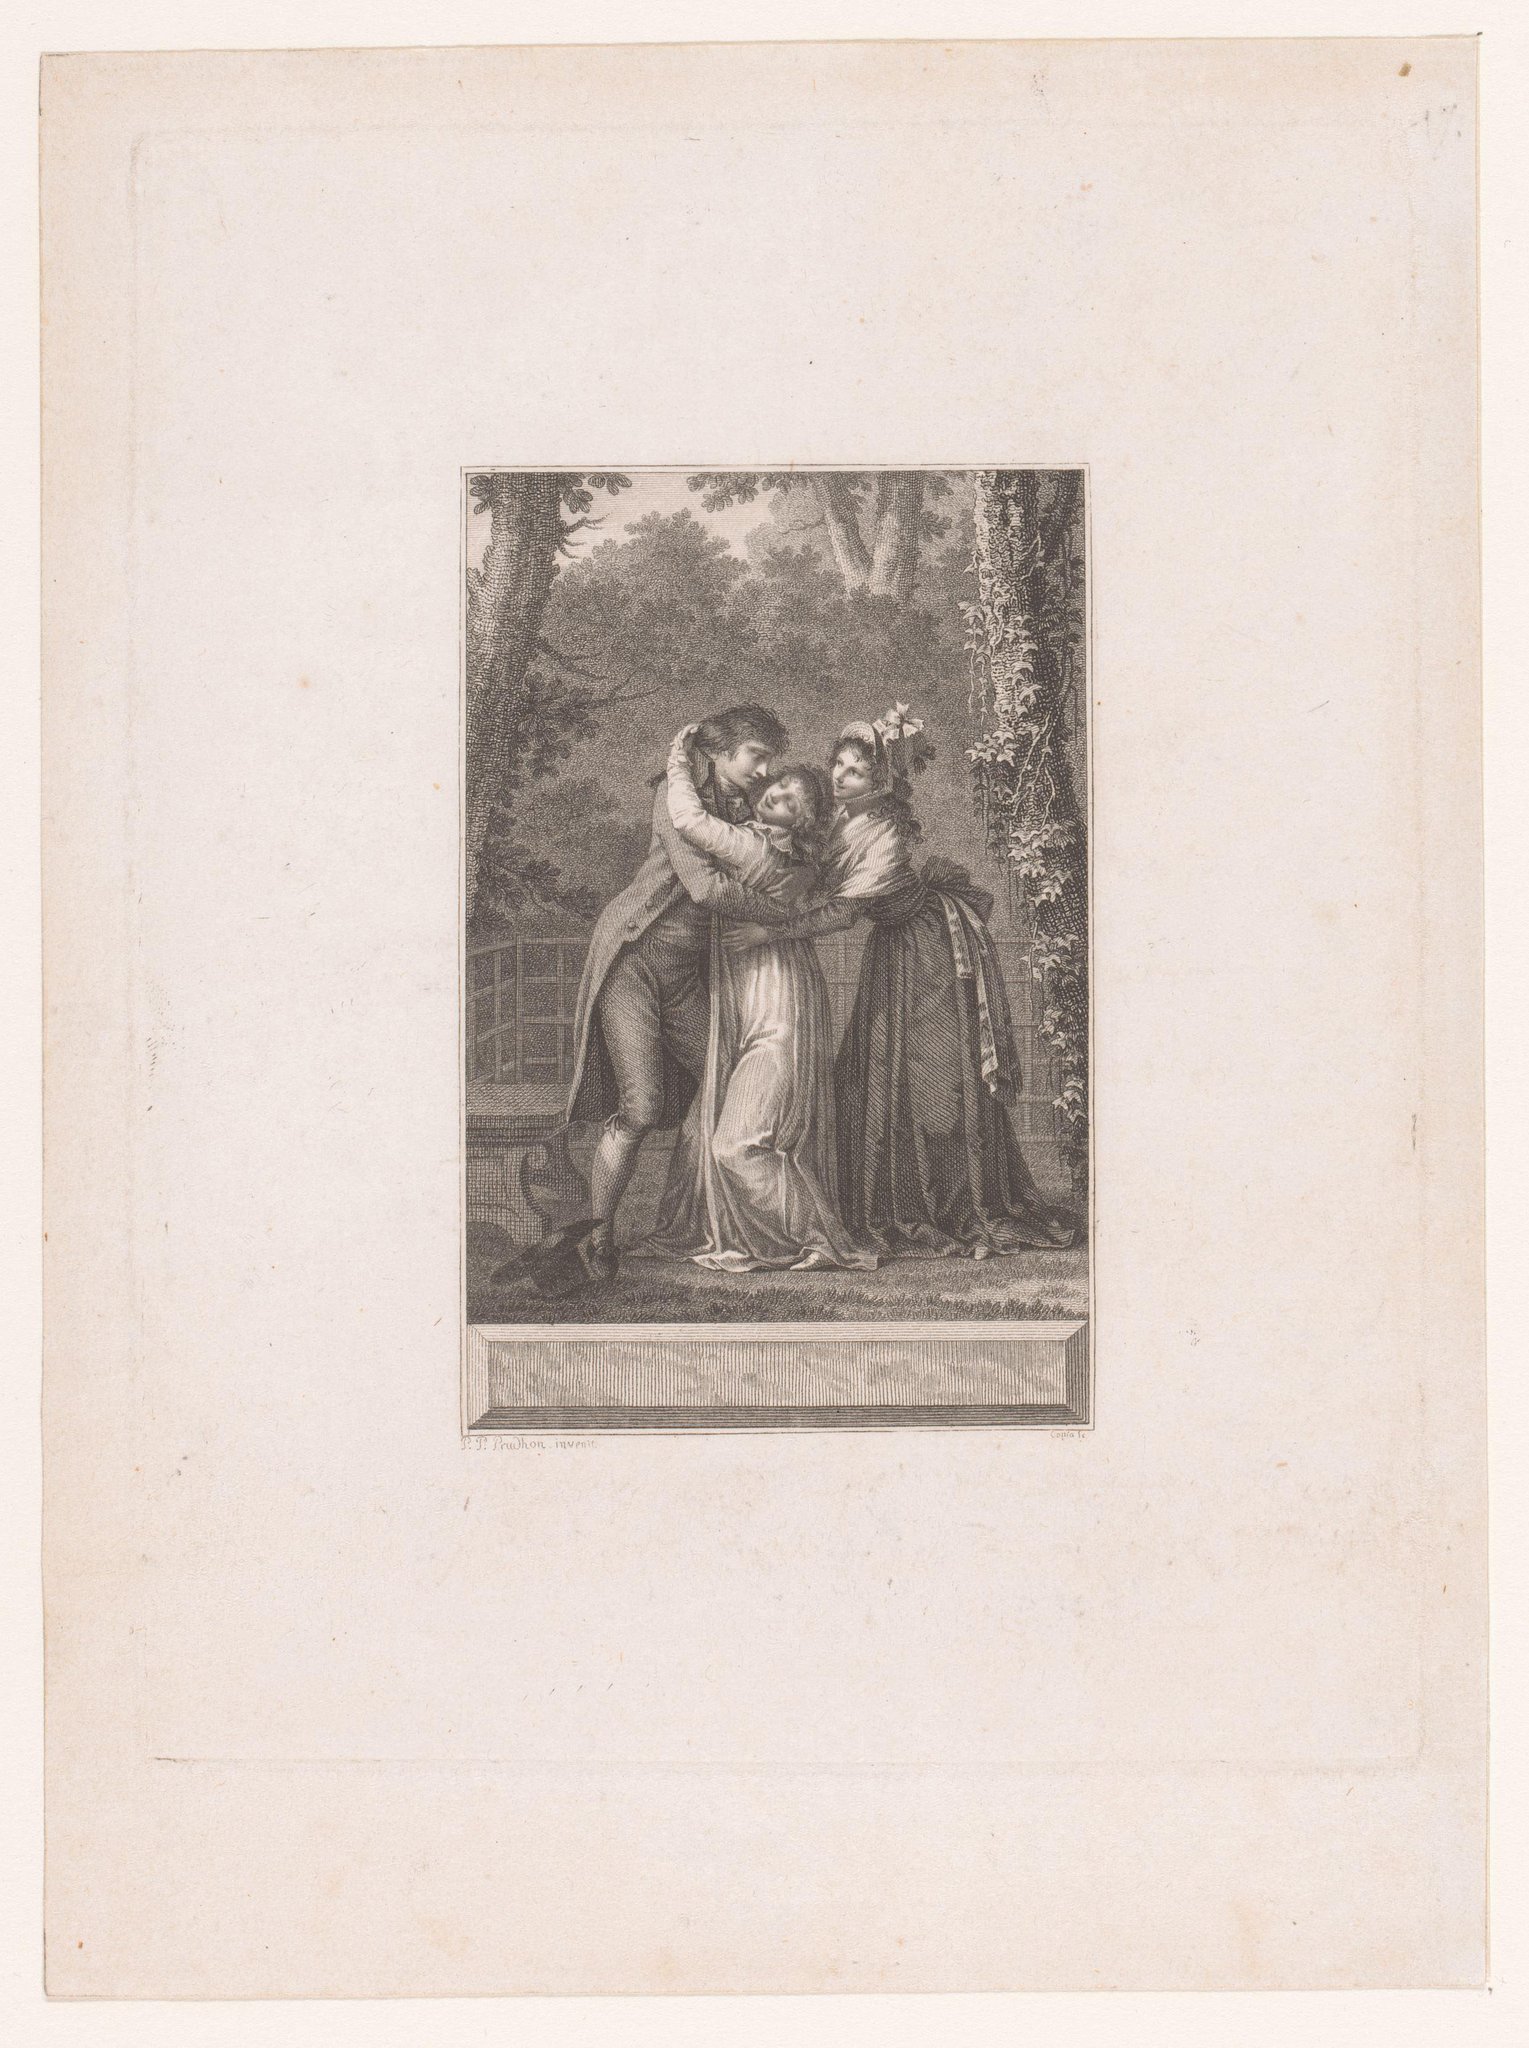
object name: book illustration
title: Le premier baiser de l'Amour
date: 1808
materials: paper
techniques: engraving, etching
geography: paris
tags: (lovers) kissing each other, literary characters and objects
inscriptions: collector's mark: Lugt 2228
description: Prent uit: Rousseau, Jean-Jacques. La nouvelle Heloïse (...). Parijs: Bossange, Masson & Besson e.a., 1808.